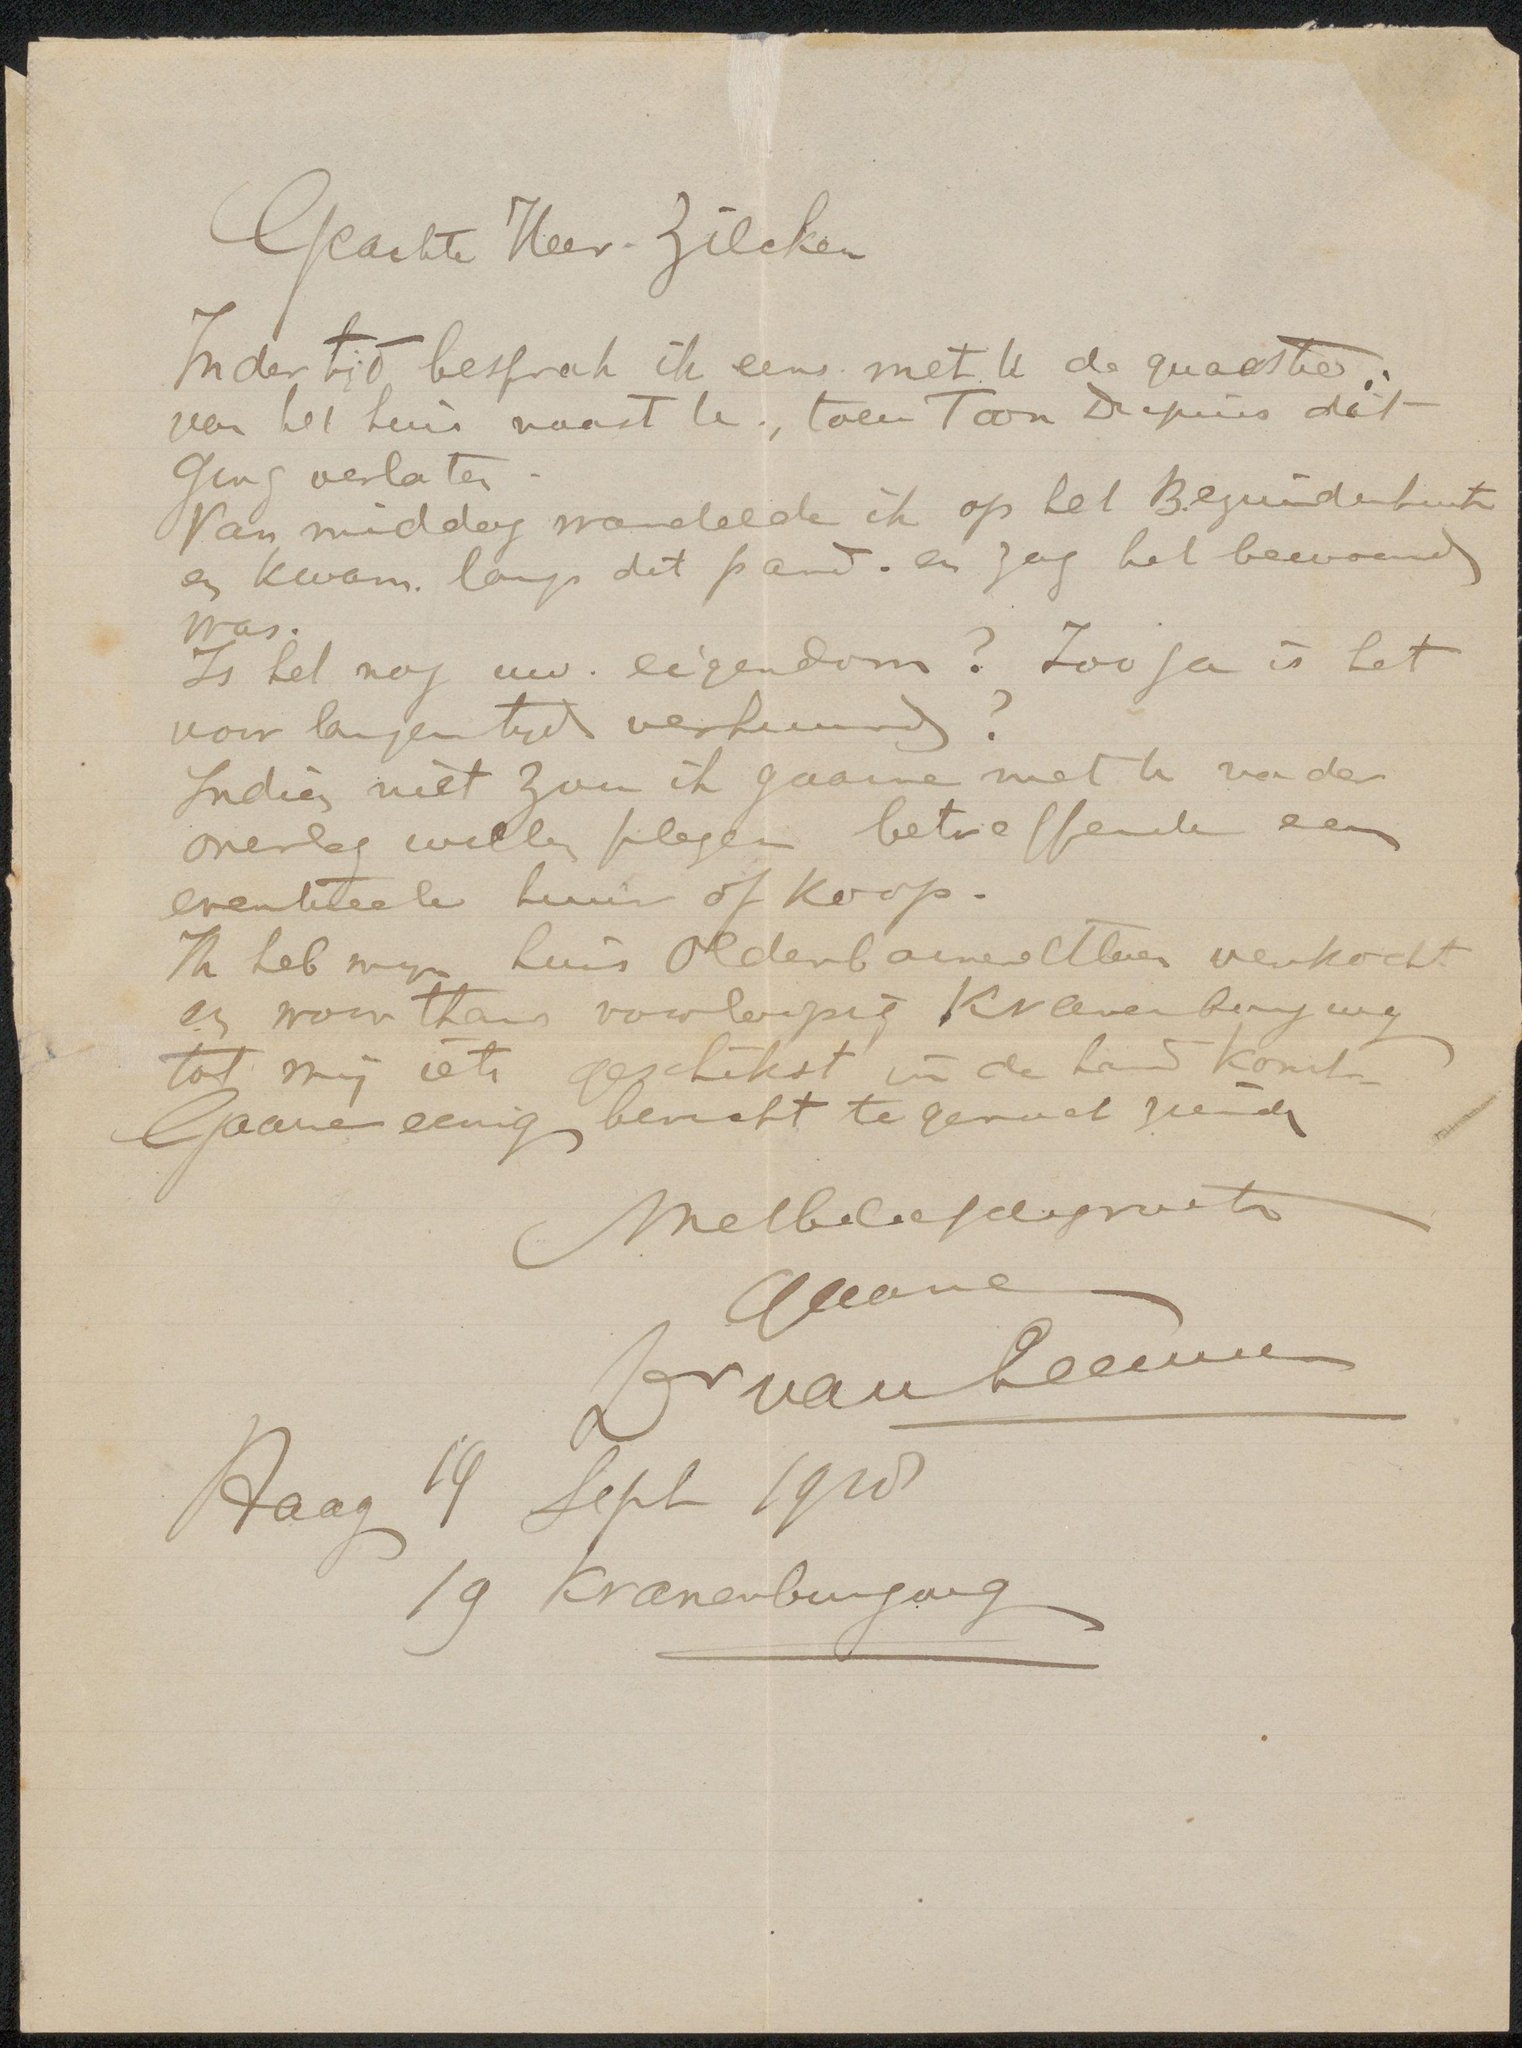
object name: letter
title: Brief aan Philip Zilcken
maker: dr. van leeuwen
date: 1918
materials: ink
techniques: pen, writing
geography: the hague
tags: the hague, painter, draughtsman, philip zilcken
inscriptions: collector's mark: ‘RPK’